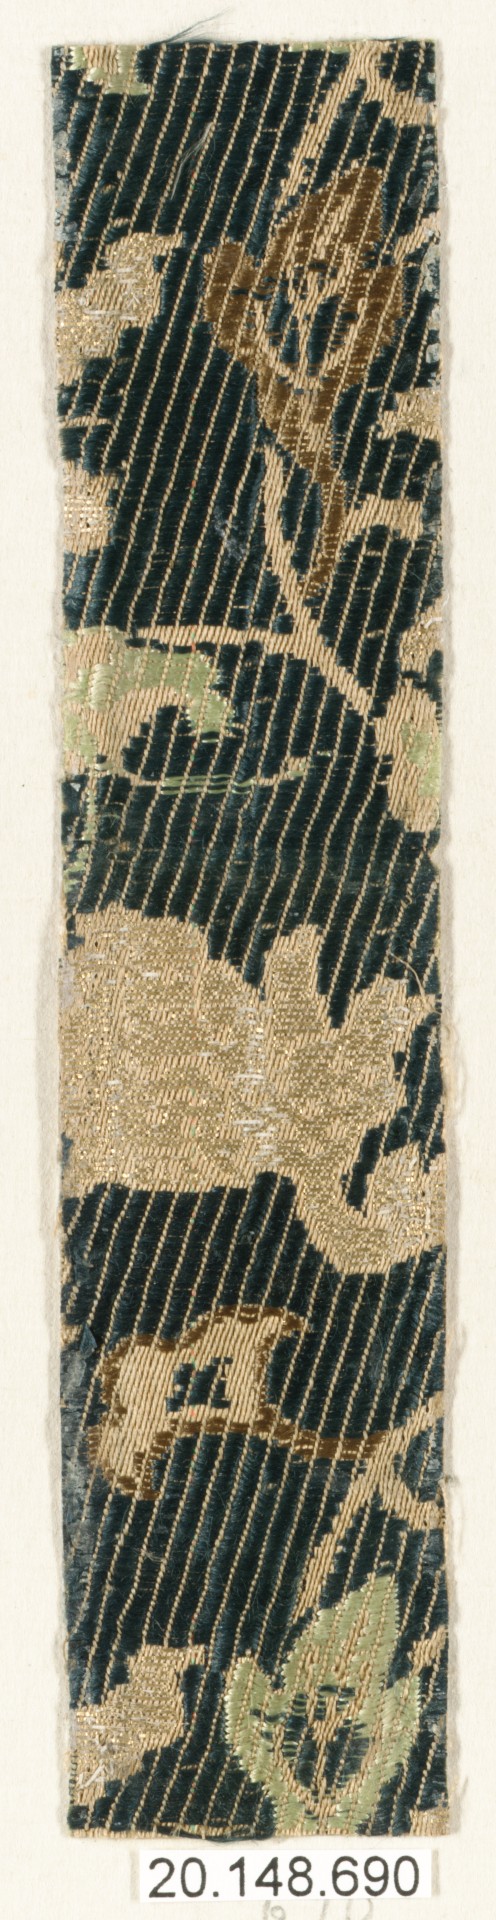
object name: piece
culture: japanese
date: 1701-1800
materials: silk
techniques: compound weave